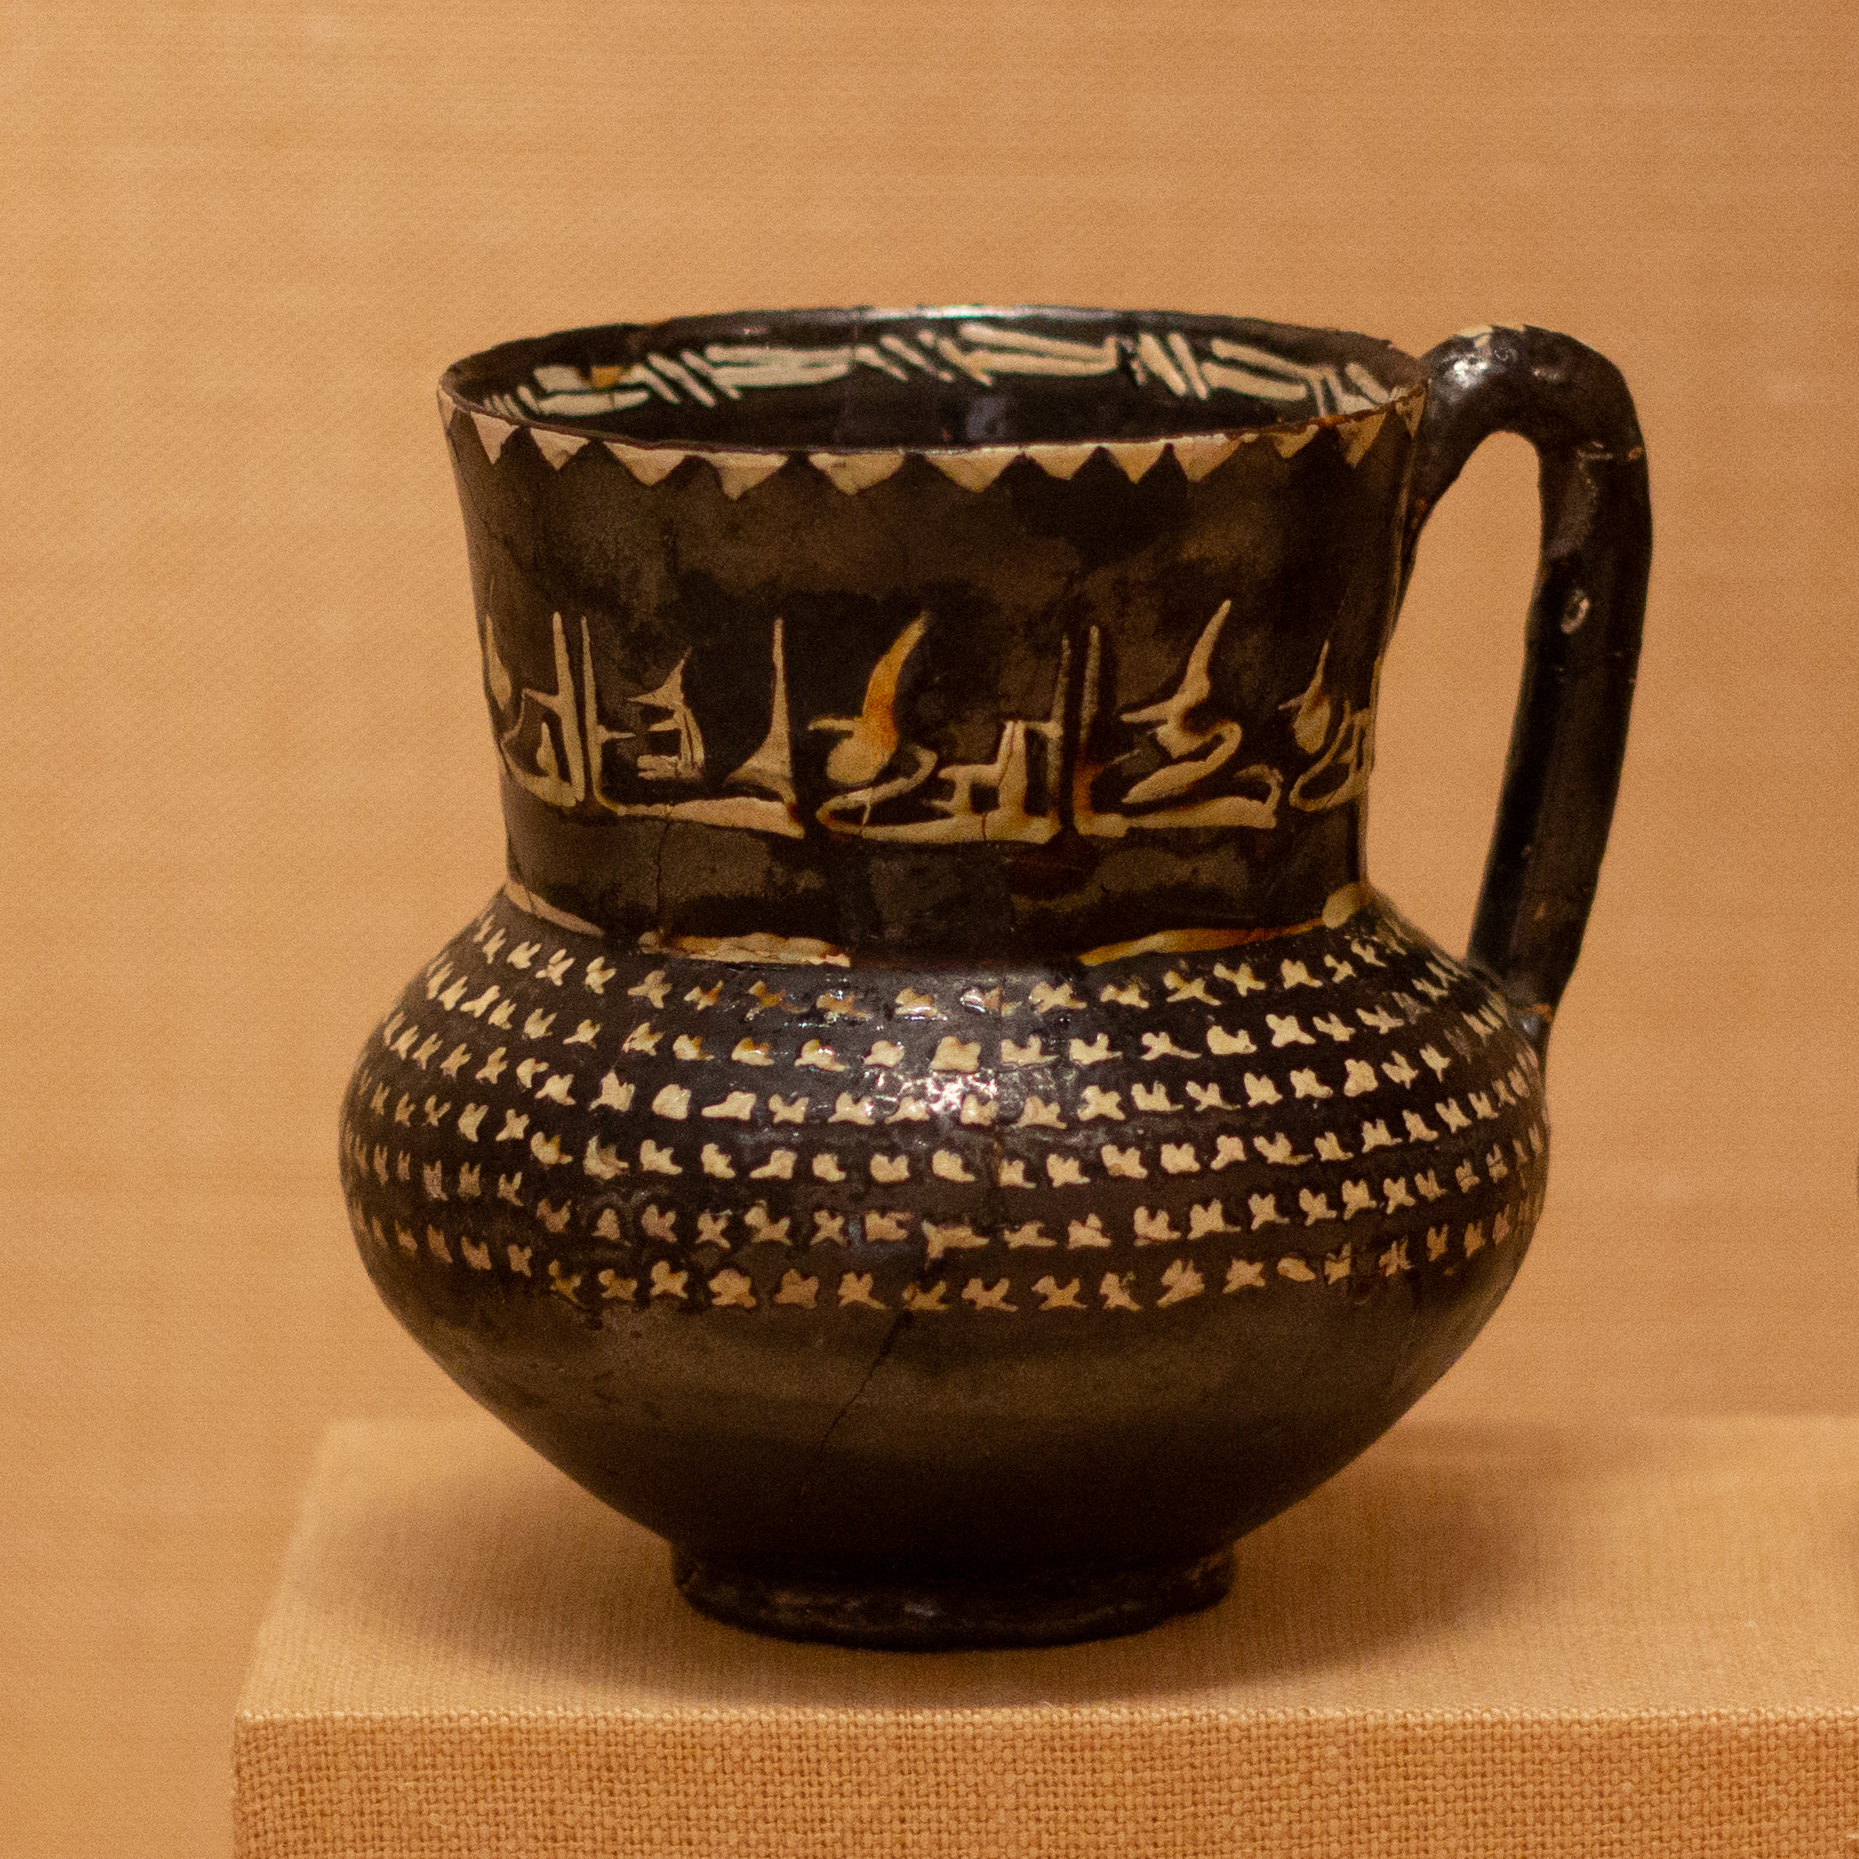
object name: ewer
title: Ewer with Repeated Arabic Phrase, "Blessing"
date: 901-1000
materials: earthenware, glaze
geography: iran